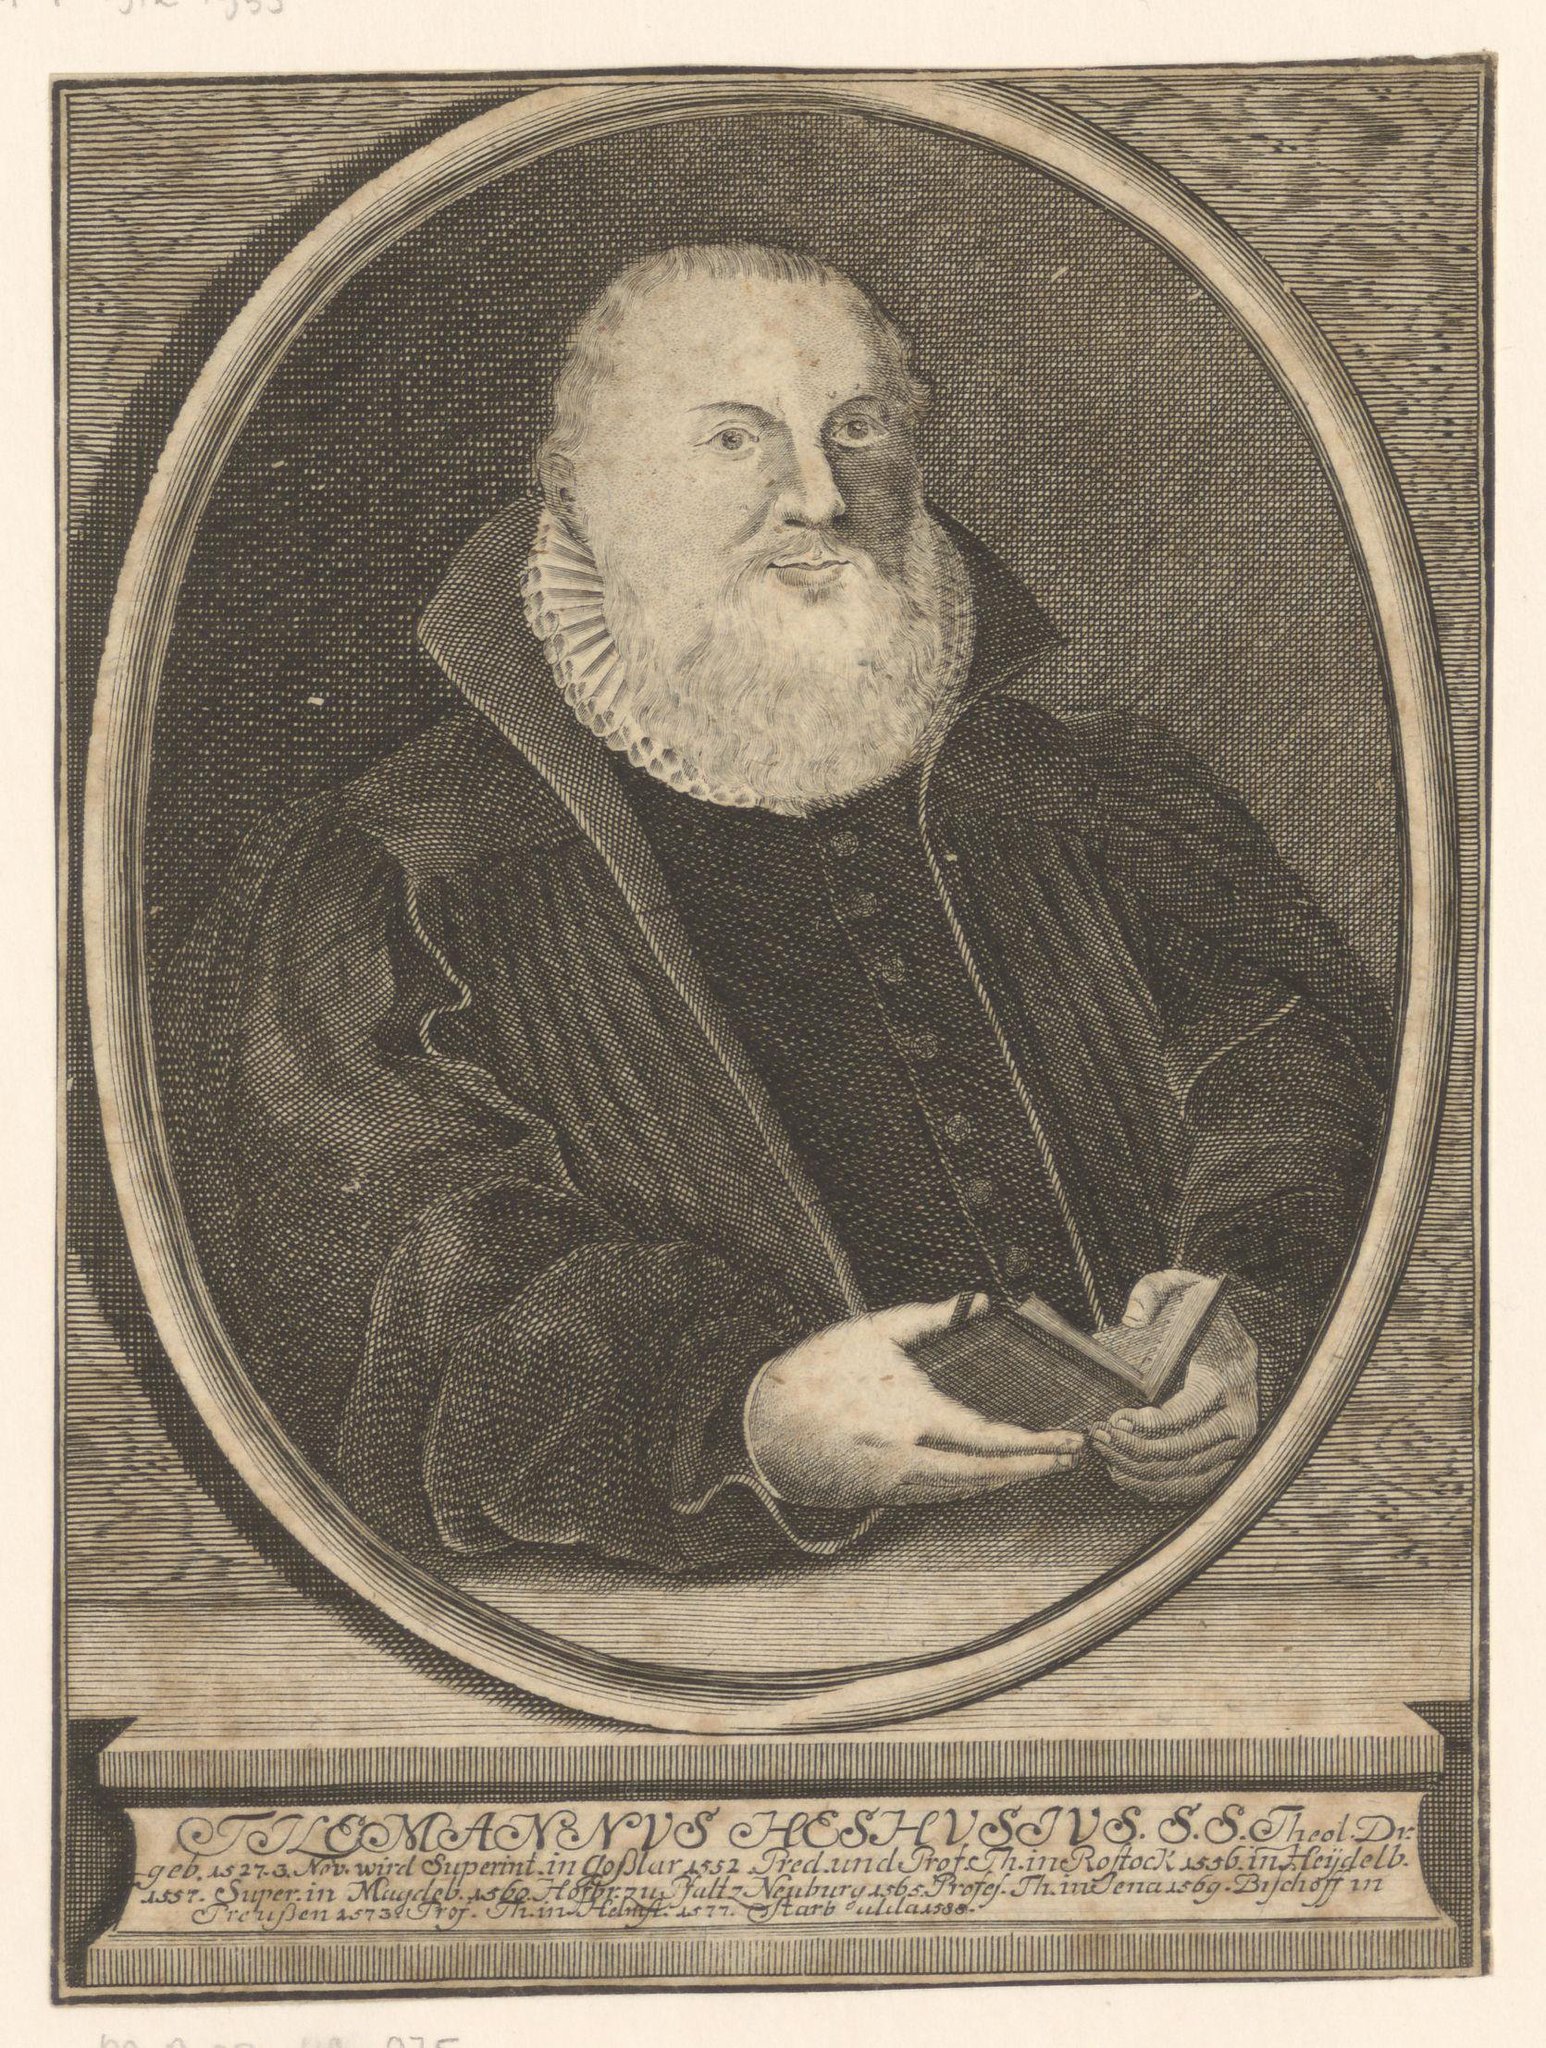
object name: print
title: Portret van Tileman Heshusen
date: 1563-1642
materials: paper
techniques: engraving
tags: historical persons, physician, doctor (+ portrait of scholar, scientist)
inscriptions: collector's mark: Lugt 2228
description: Deze kopie van een prent door Balthasar Jenichen hoort bij een serie portretten van sturende personen tijdens de reformatie, gebruikt in: Agricola, Johann. Bildnüs und Abcontrafactur etzlicher Vornemer Gelerten Menner, durch welche Gott aus sonderbaren gnaden, die rechte reine Warheit des heiligen Evangelii, zu diesen unsern und beschrieben (...). Dresden: Gimmel Bergen, 1588.